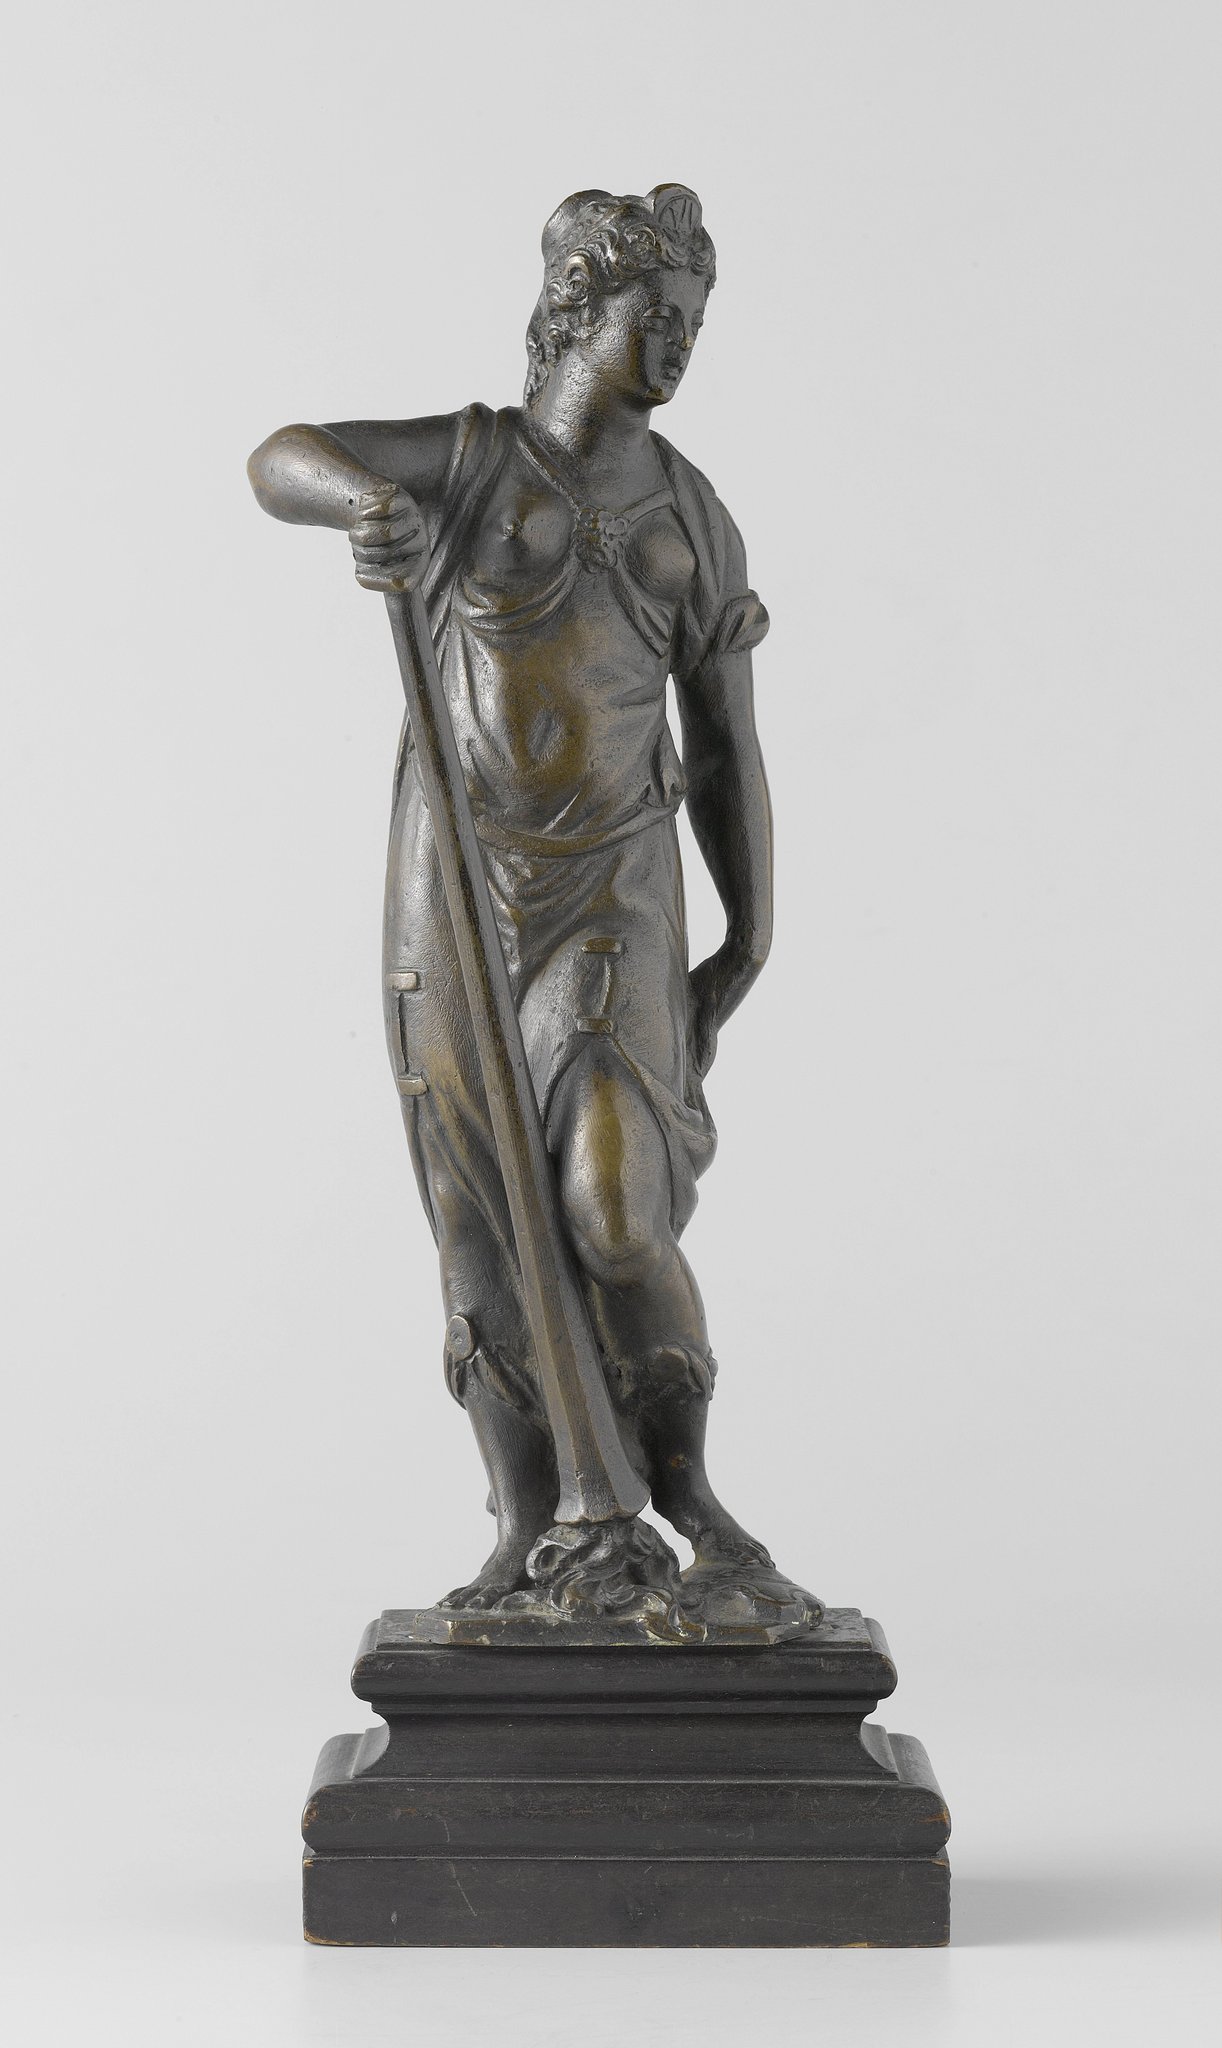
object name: sculpture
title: Vrouwenfiguur met omgekeerde fakkel: De Vrede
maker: Anonymous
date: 1800-1899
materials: bronze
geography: venice